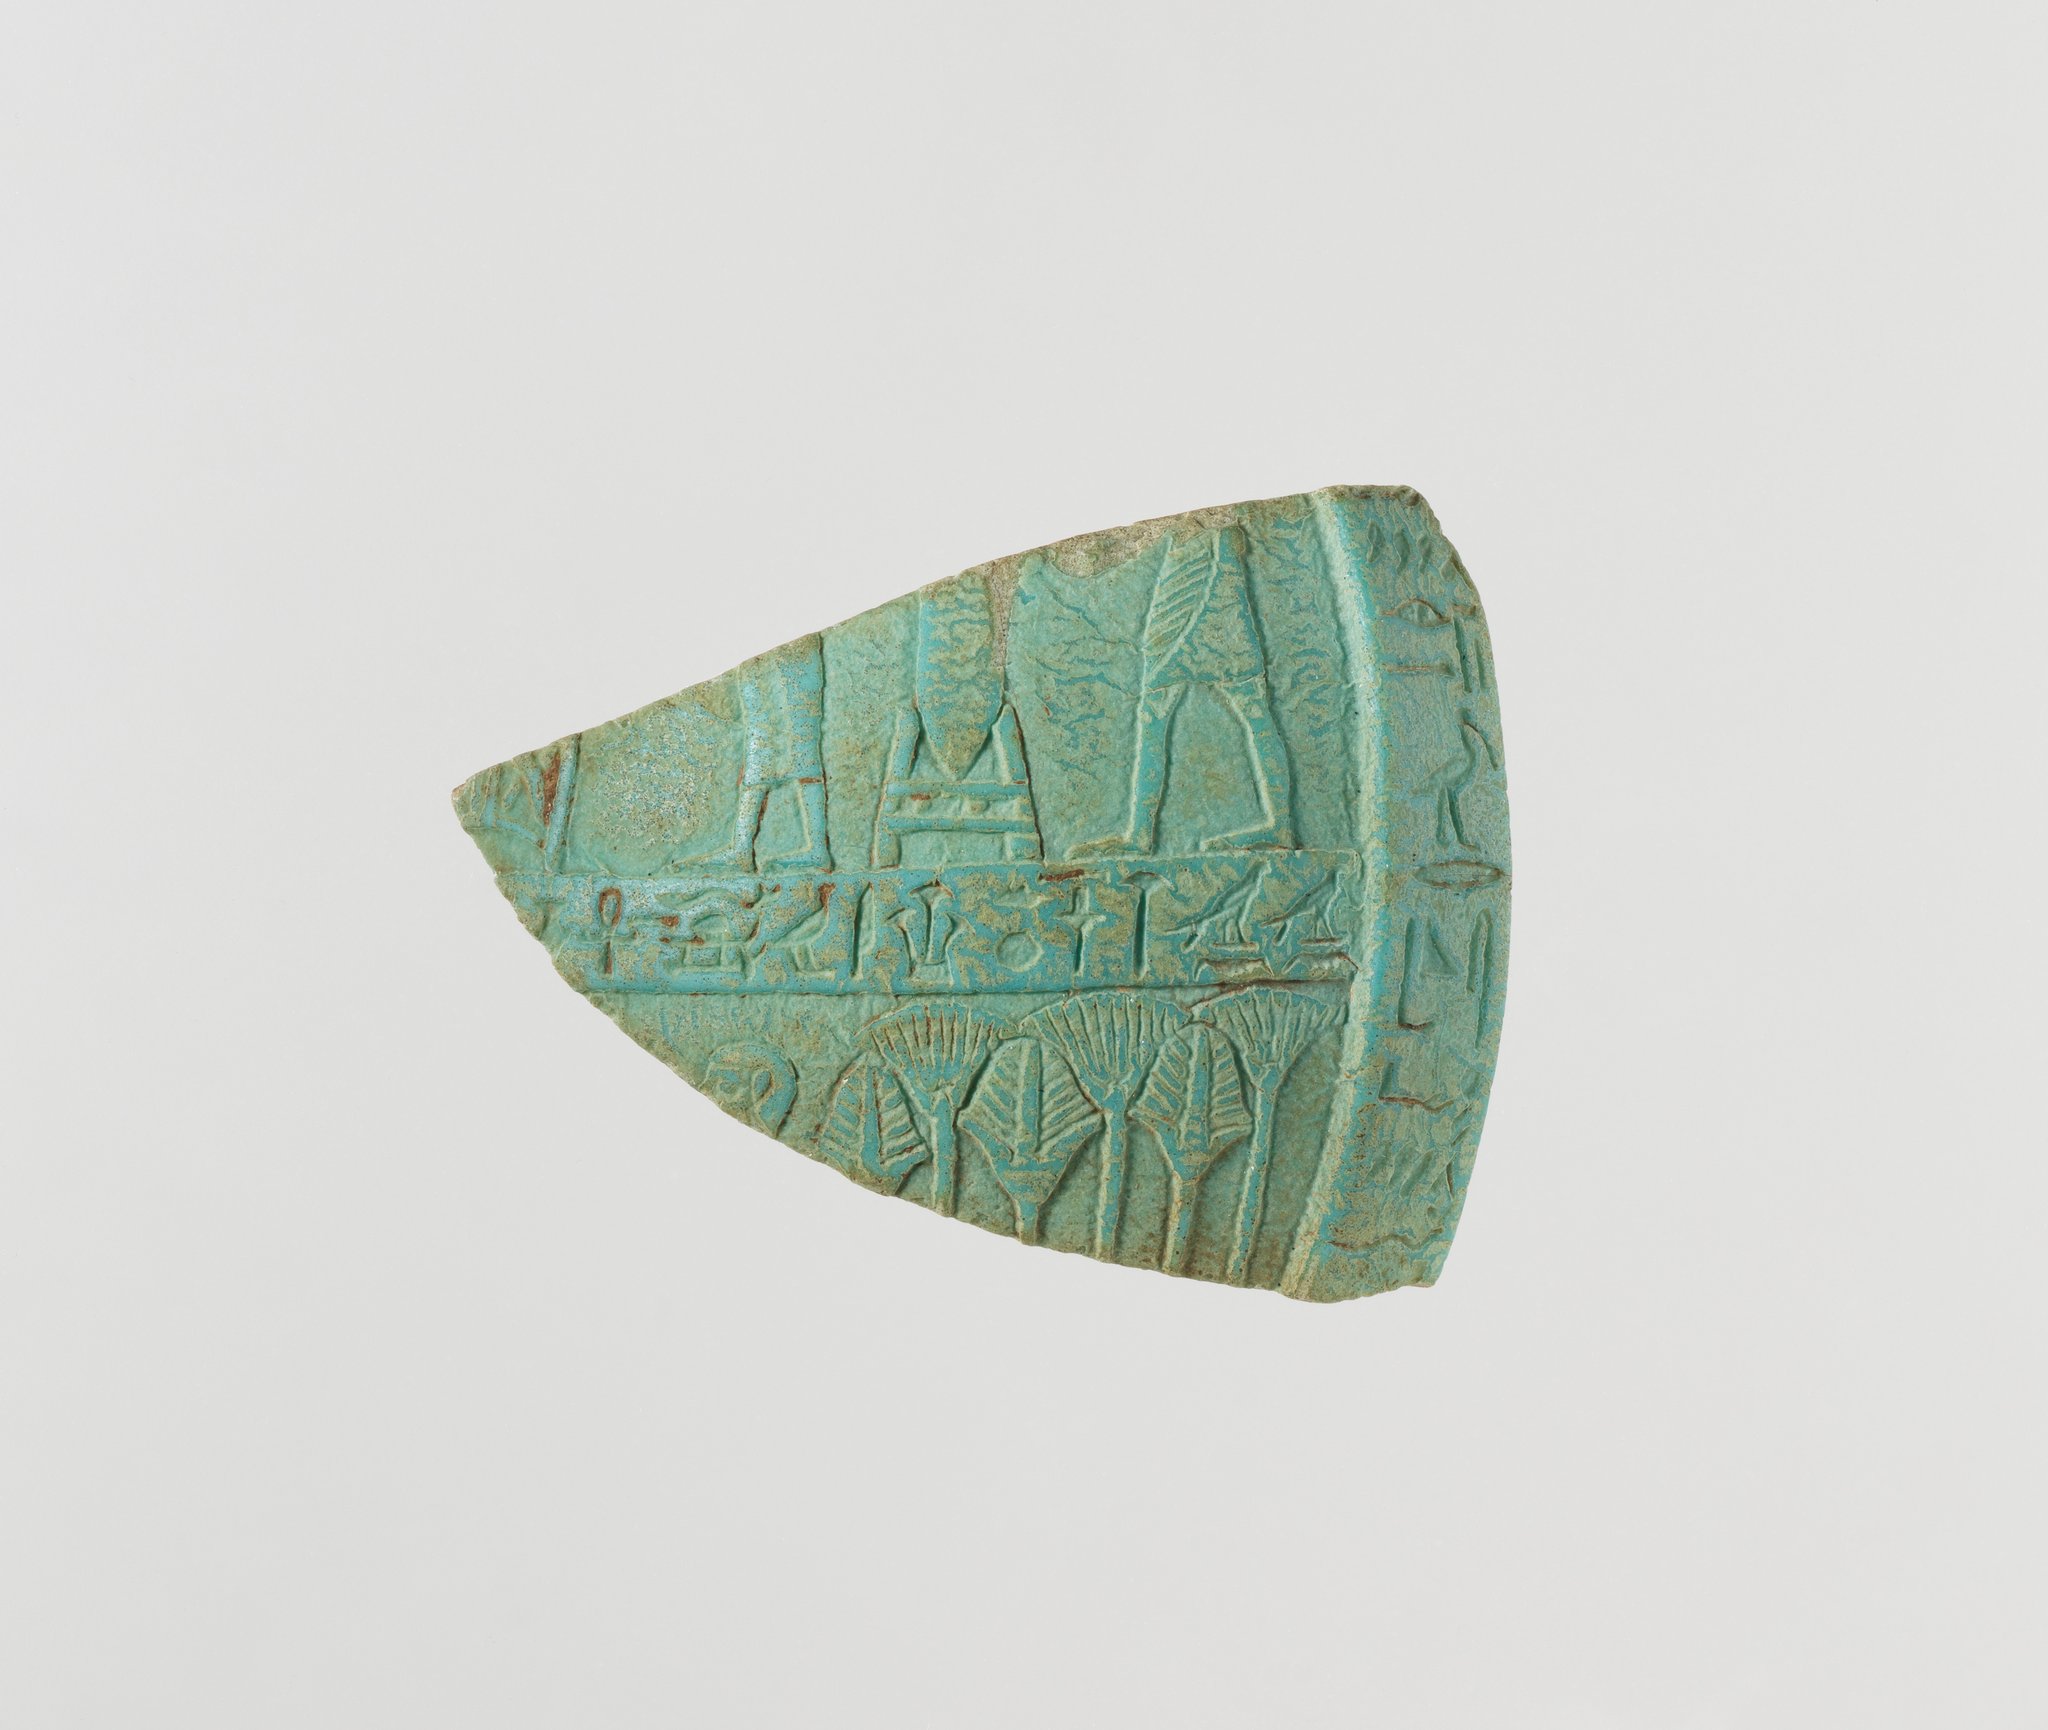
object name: flask fragment, decorated, new year's, ointment, chalice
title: Fragment of a decorated New Year's flask unusually intended for ointment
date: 664-525 BCE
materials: faience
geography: egypt